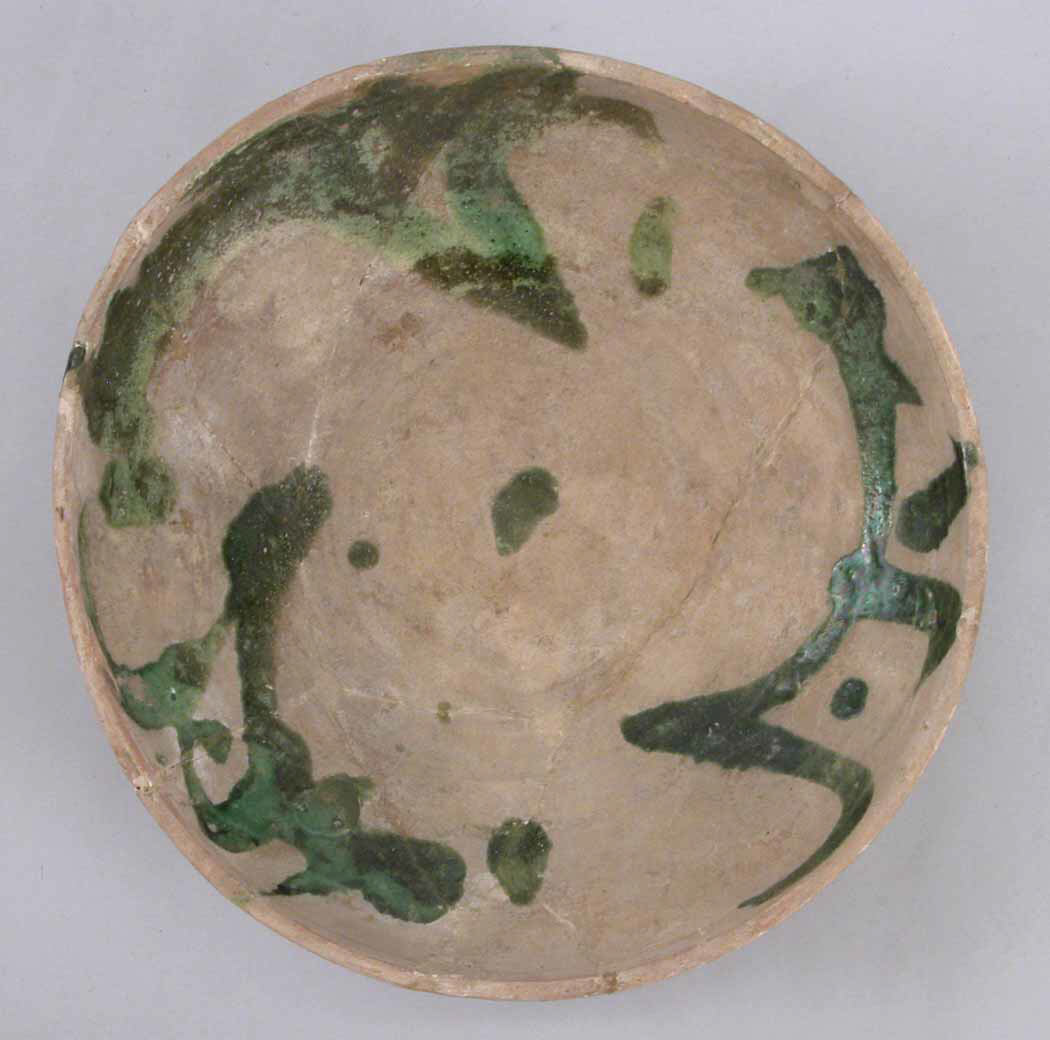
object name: bowl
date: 801-1000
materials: earthenware, glaze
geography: iran